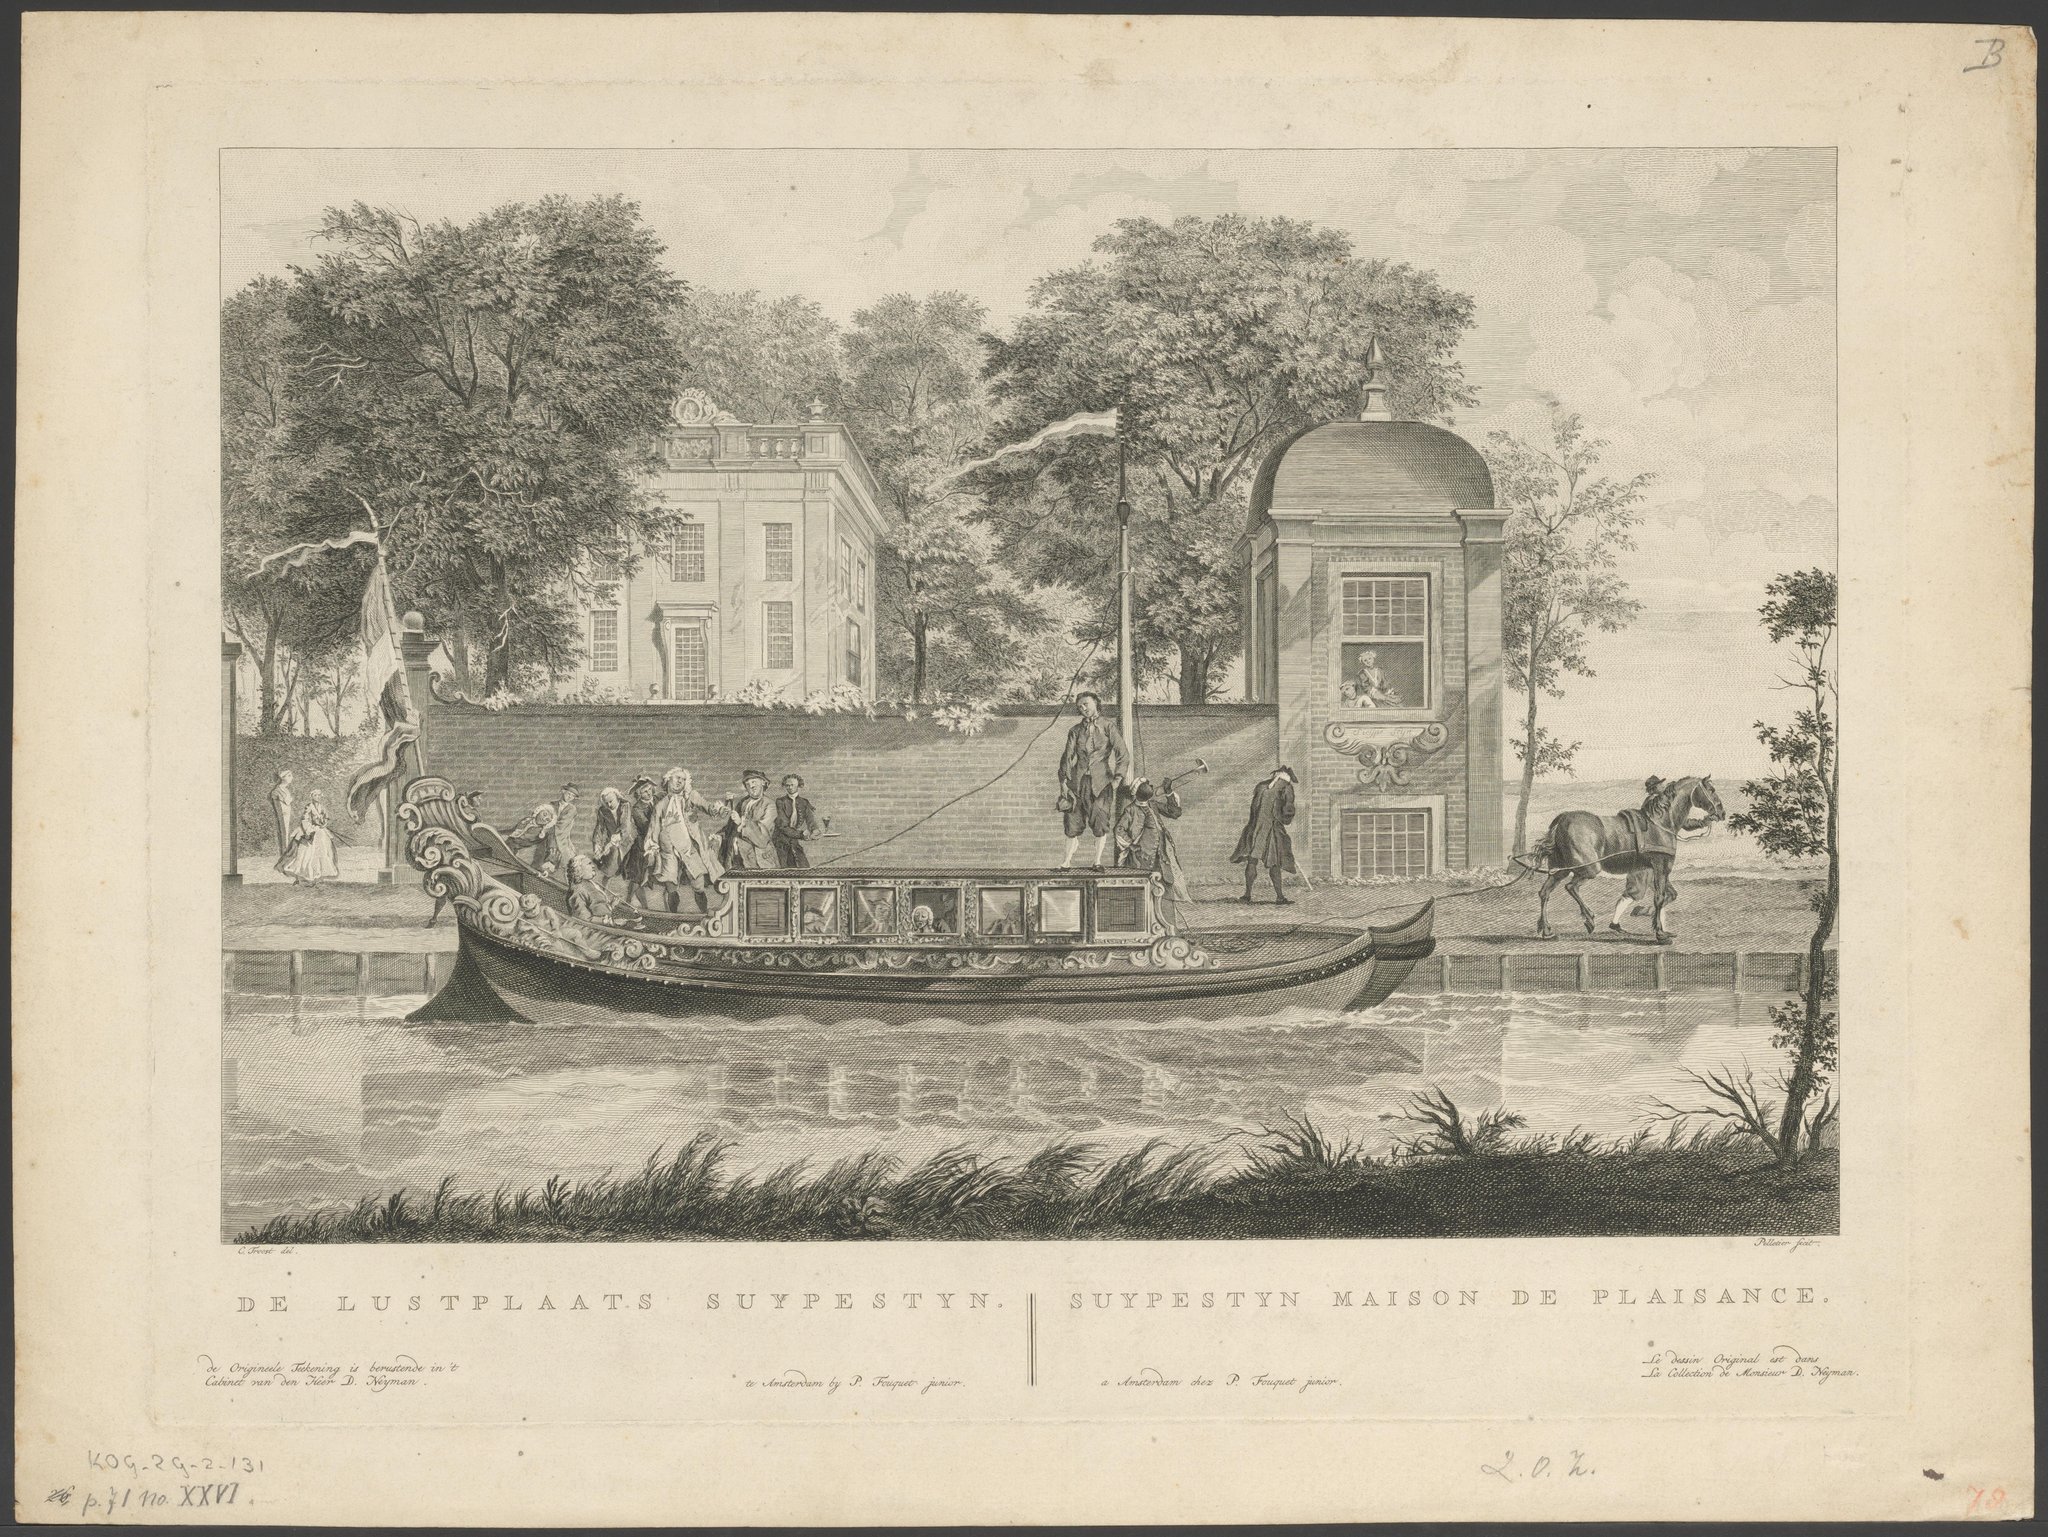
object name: print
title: Buitenplaats met dronken gezelschap dat aan boord gaat van een trekschuit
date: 1754-1764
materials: paper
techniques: engraving, etching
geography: amsterdam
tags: (descendants of) african emigrants, person migrating from africa (the netherlands), rural housing, e.g. country-house, villa, cottage, horn, trumpet, cornet, trombone, tuba - cc - out of doors, tow-boat, towing-barge, drunkenness, urination, house personnel, servants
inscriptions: collector's mark: Lugt 2488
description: Buitenplaats met dronken gezelschap dat aan boord gaat van een trekschuit. Een man plast nog even tegen een muur. Aan boord blaast een zwarte jongen op een trompet.